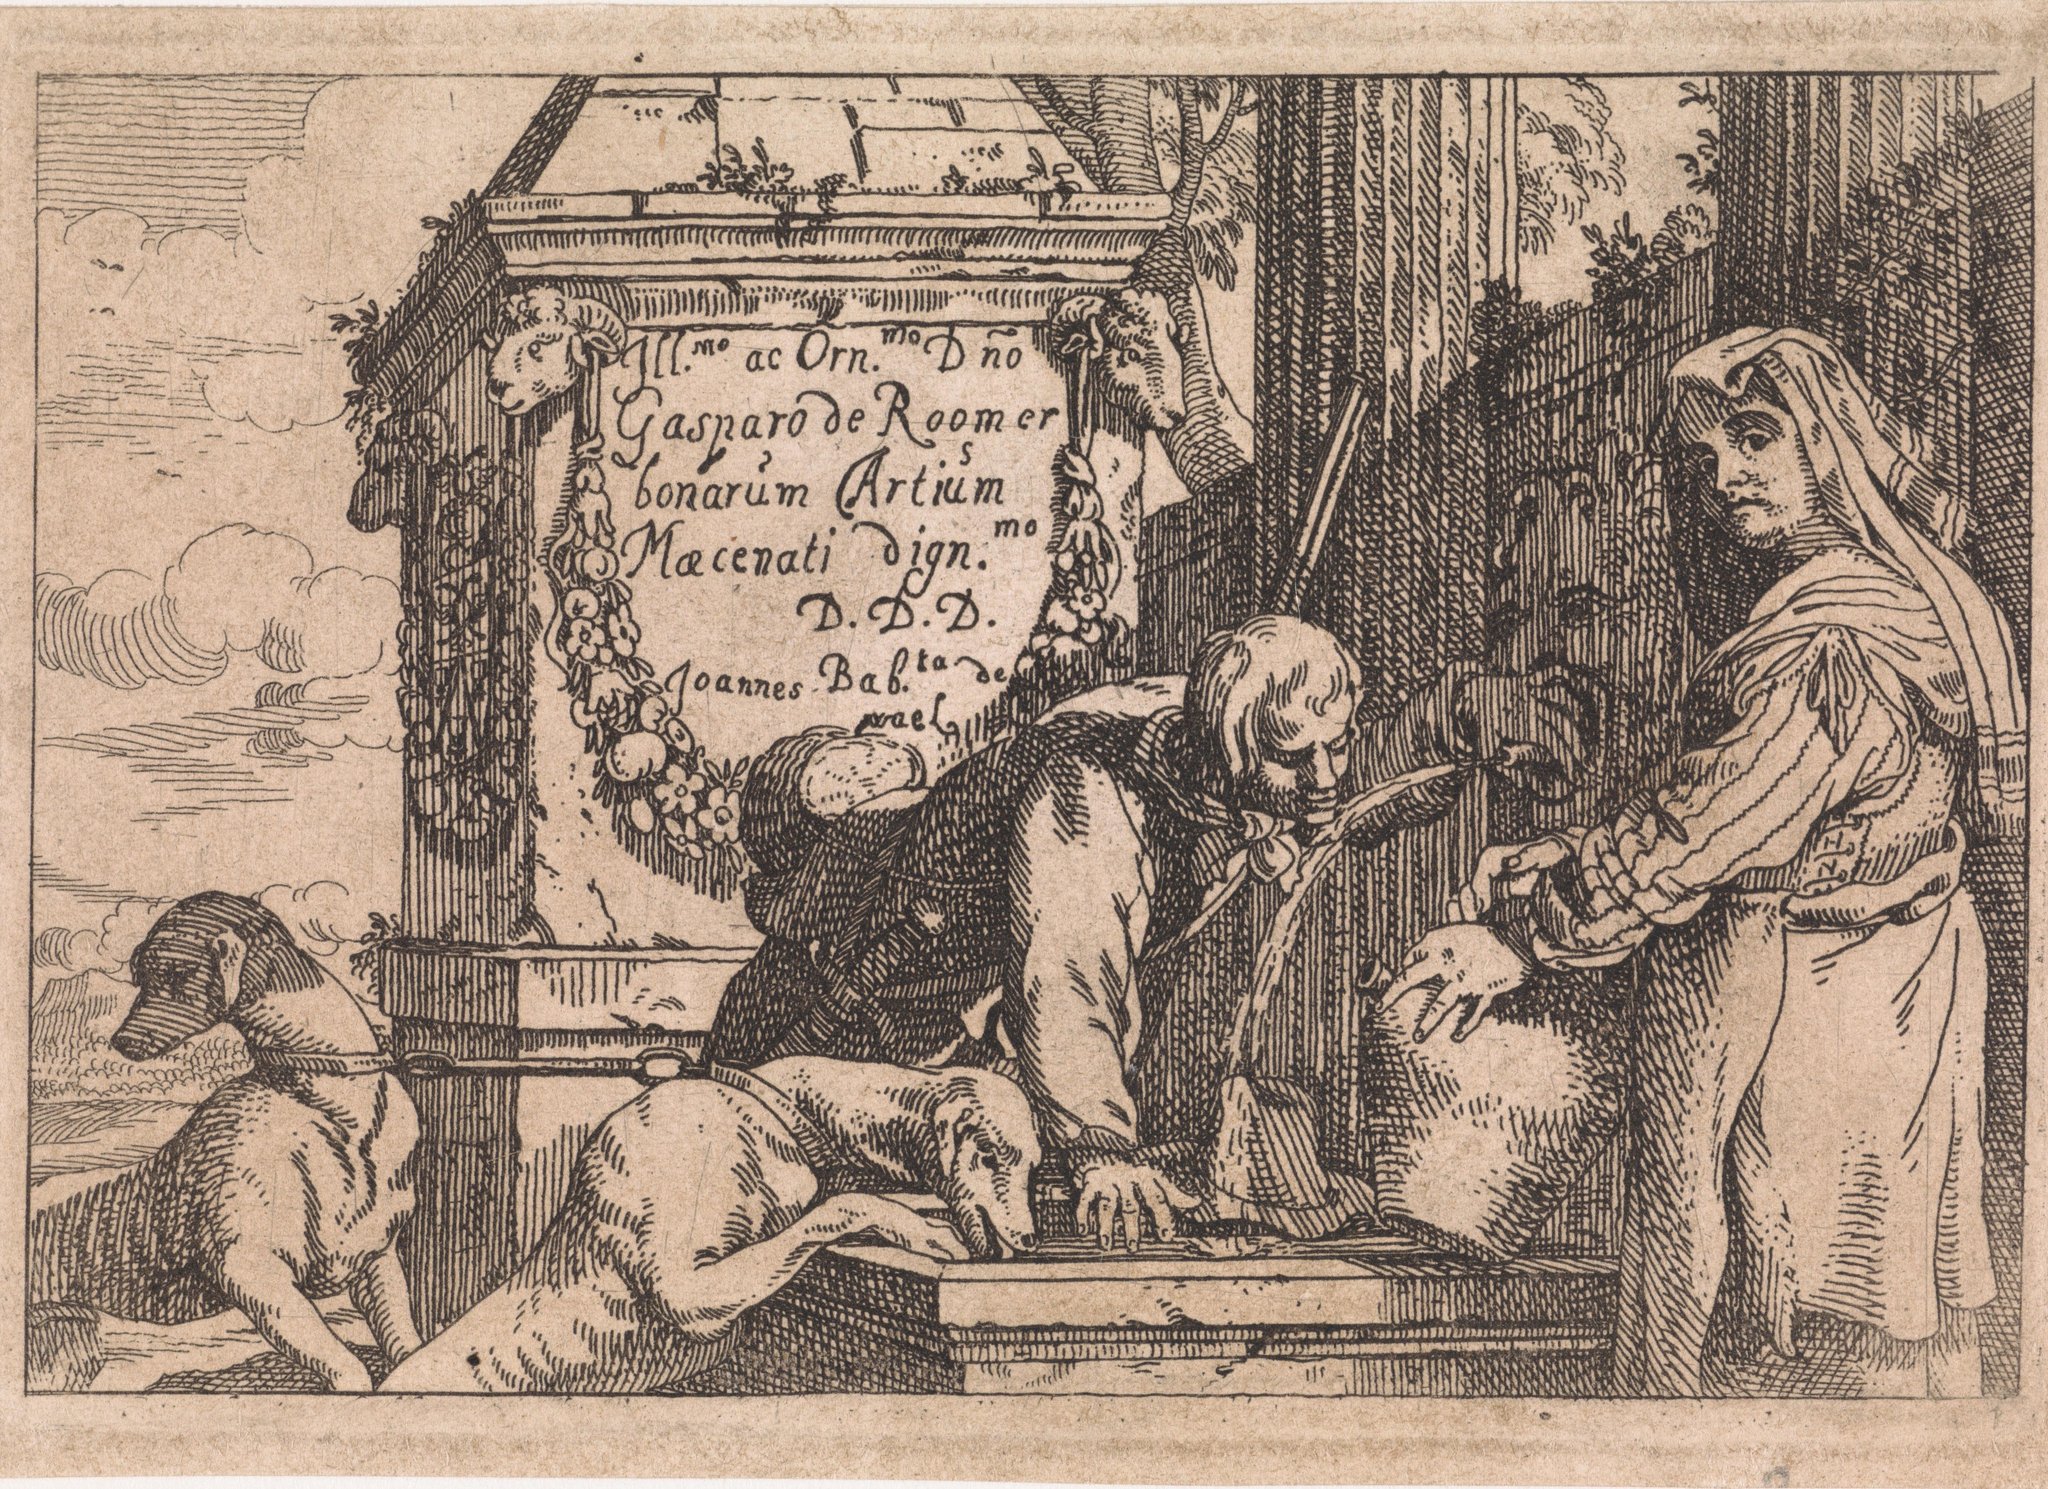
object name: titelprent, frontispice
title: Diverse genretaferelen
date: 1642-1669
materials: paper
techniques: etching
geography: genoa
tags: hunter, garden fountain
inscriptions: collector's mark: Lugt 2228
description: Een jager drinkt water uit een fontein. Hij is vergezeld door zijn jachthonden. Een vrouw staat langs de rand, met een emmer in de handen, en kijkt de beschouwer aan. Op de achtergrond een klassiek monument met op de hoeken ramskoppen, waarop een opdracht in het Latijn.